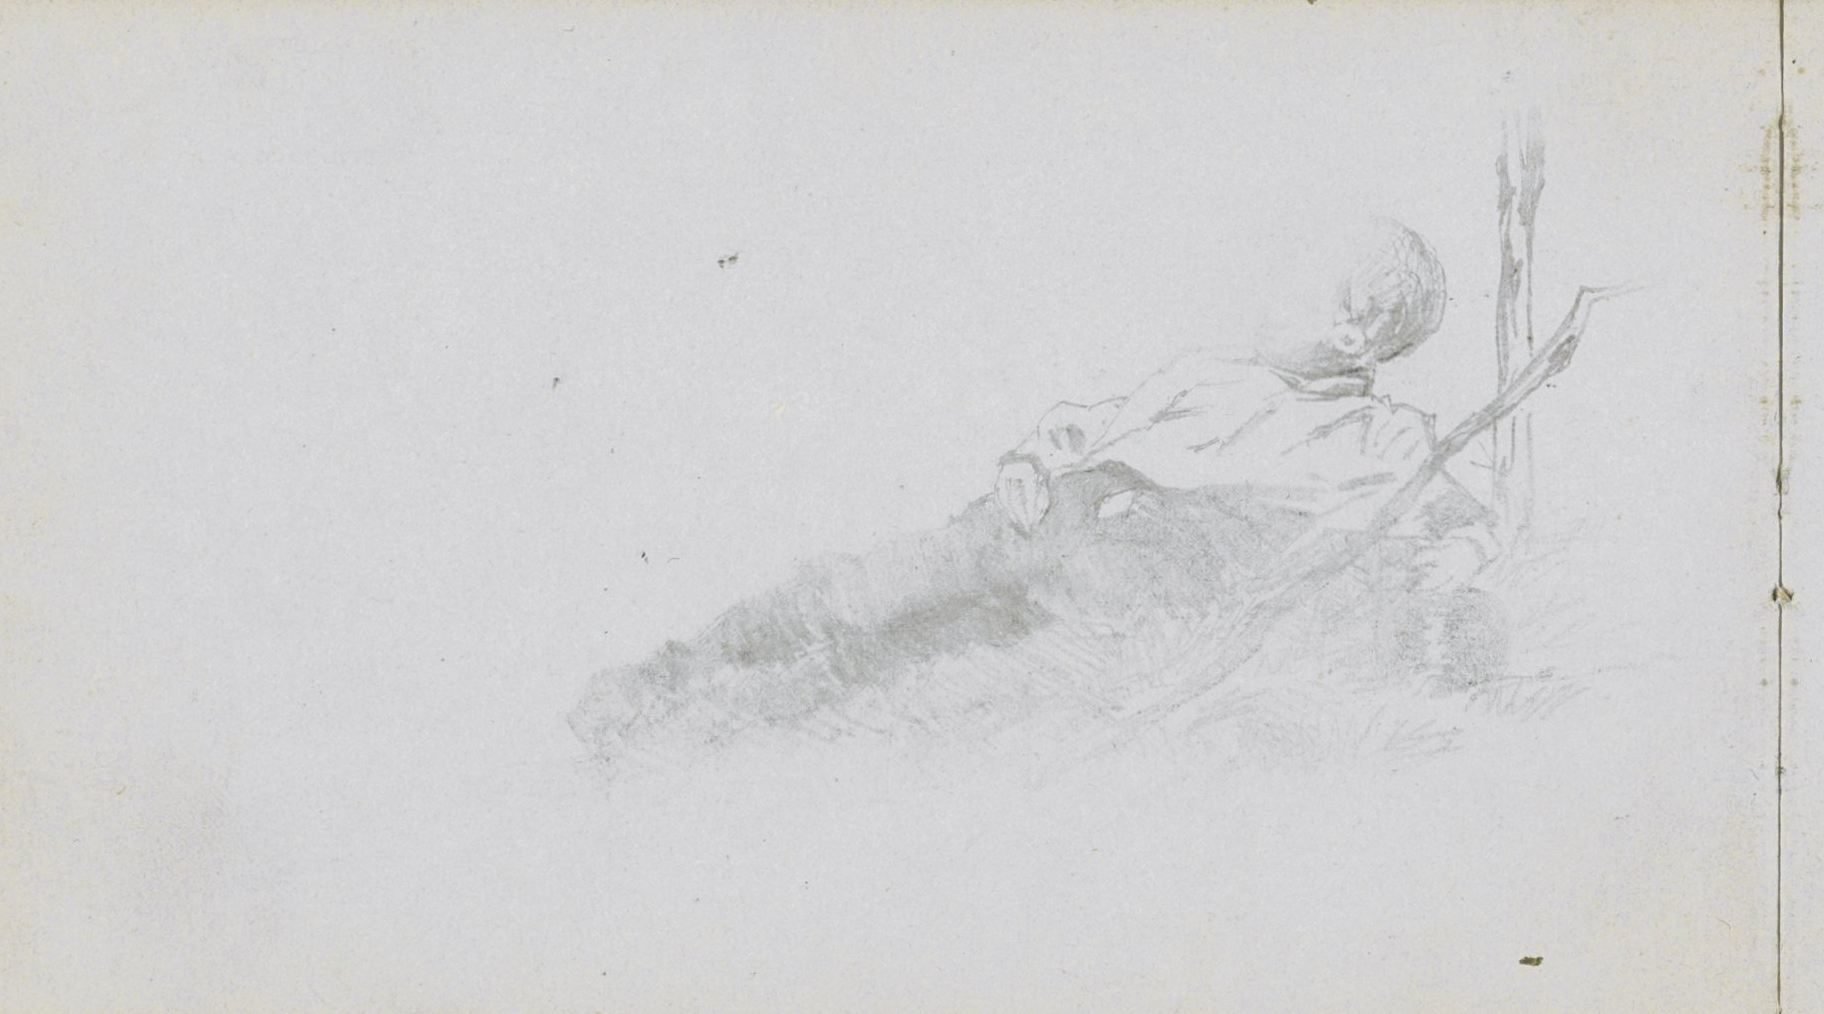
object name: sketchbook leaf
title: Abklatsch van de tekening op pagina 20 recto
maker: johan hendrik weissenbruch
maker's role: draughtsman, painter, print maker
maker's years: 1824-1903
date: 1834-1903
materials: paper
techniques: printmaking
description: Blad 19 verso uit een schetsboek met 39 bladen.